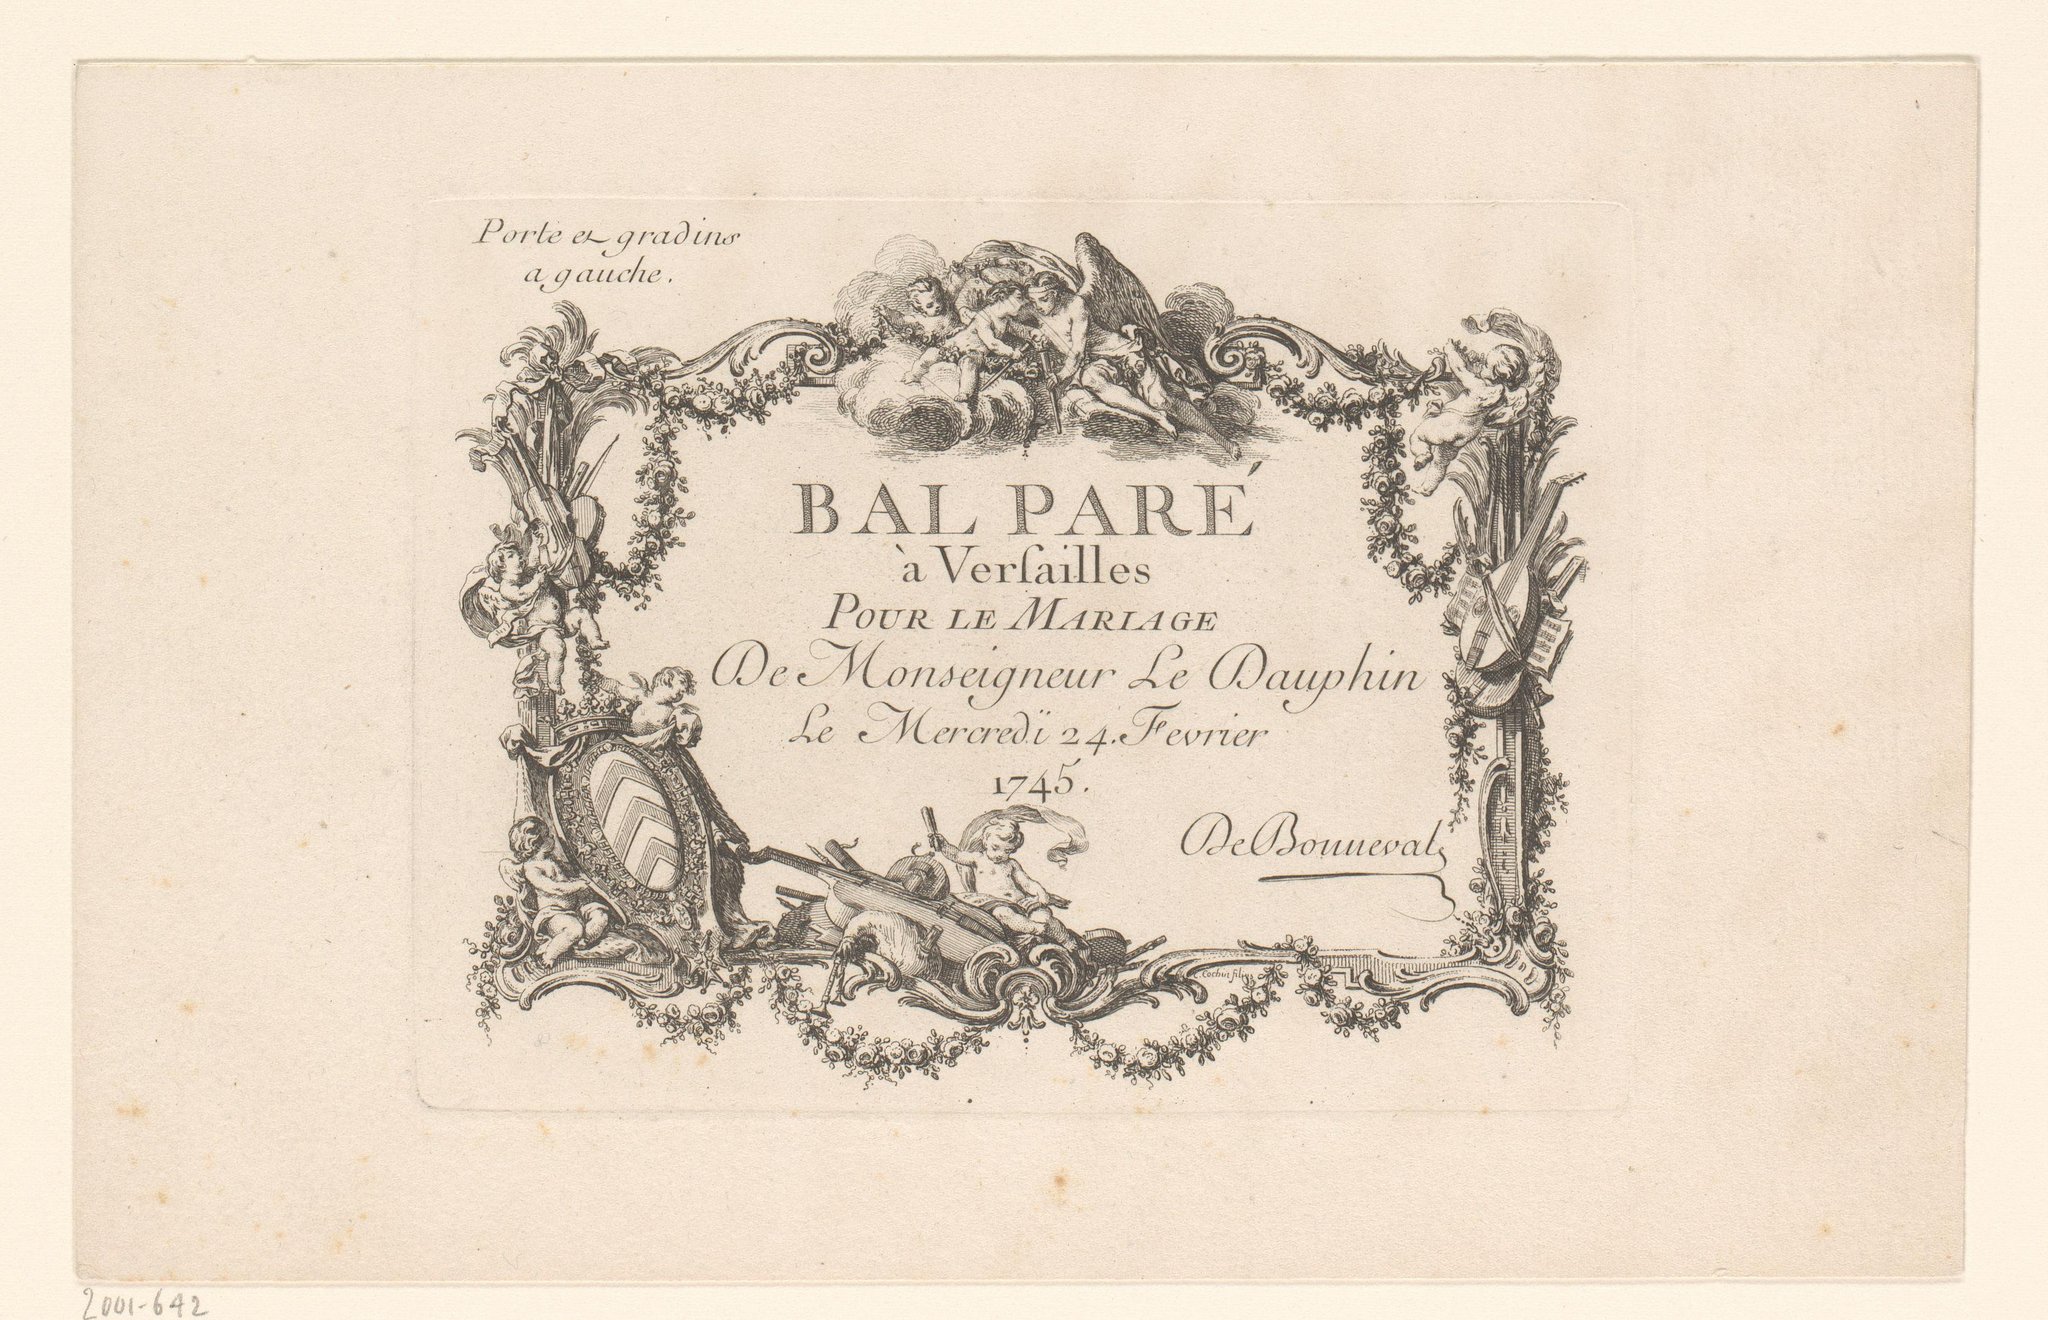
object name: invitation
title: Uitnodiging voor het 'Bal Paré a Versailles pour le Mariage de Monseigneur Le Dauphin' op 24 februari 1745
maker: Anonymous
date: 1745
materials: paper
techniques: engraving, etching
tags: lodewijk van frankrijk (dauphin van frankrijk), ornaments ~ art, cupids: 'amores', 'amoretti', 'putti'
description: Ornamenteel kader met putti, muziekinstrumenten en bloemenslingers. Daarin de tekst van de uitnodiging van het bal ter ere van het huwelijk van Lodewijk Ferdinand, dauphin van Frankrijk, met infante Maria Theresia van Bourbon. Rechtsonder de naam 'De Bonneval'.